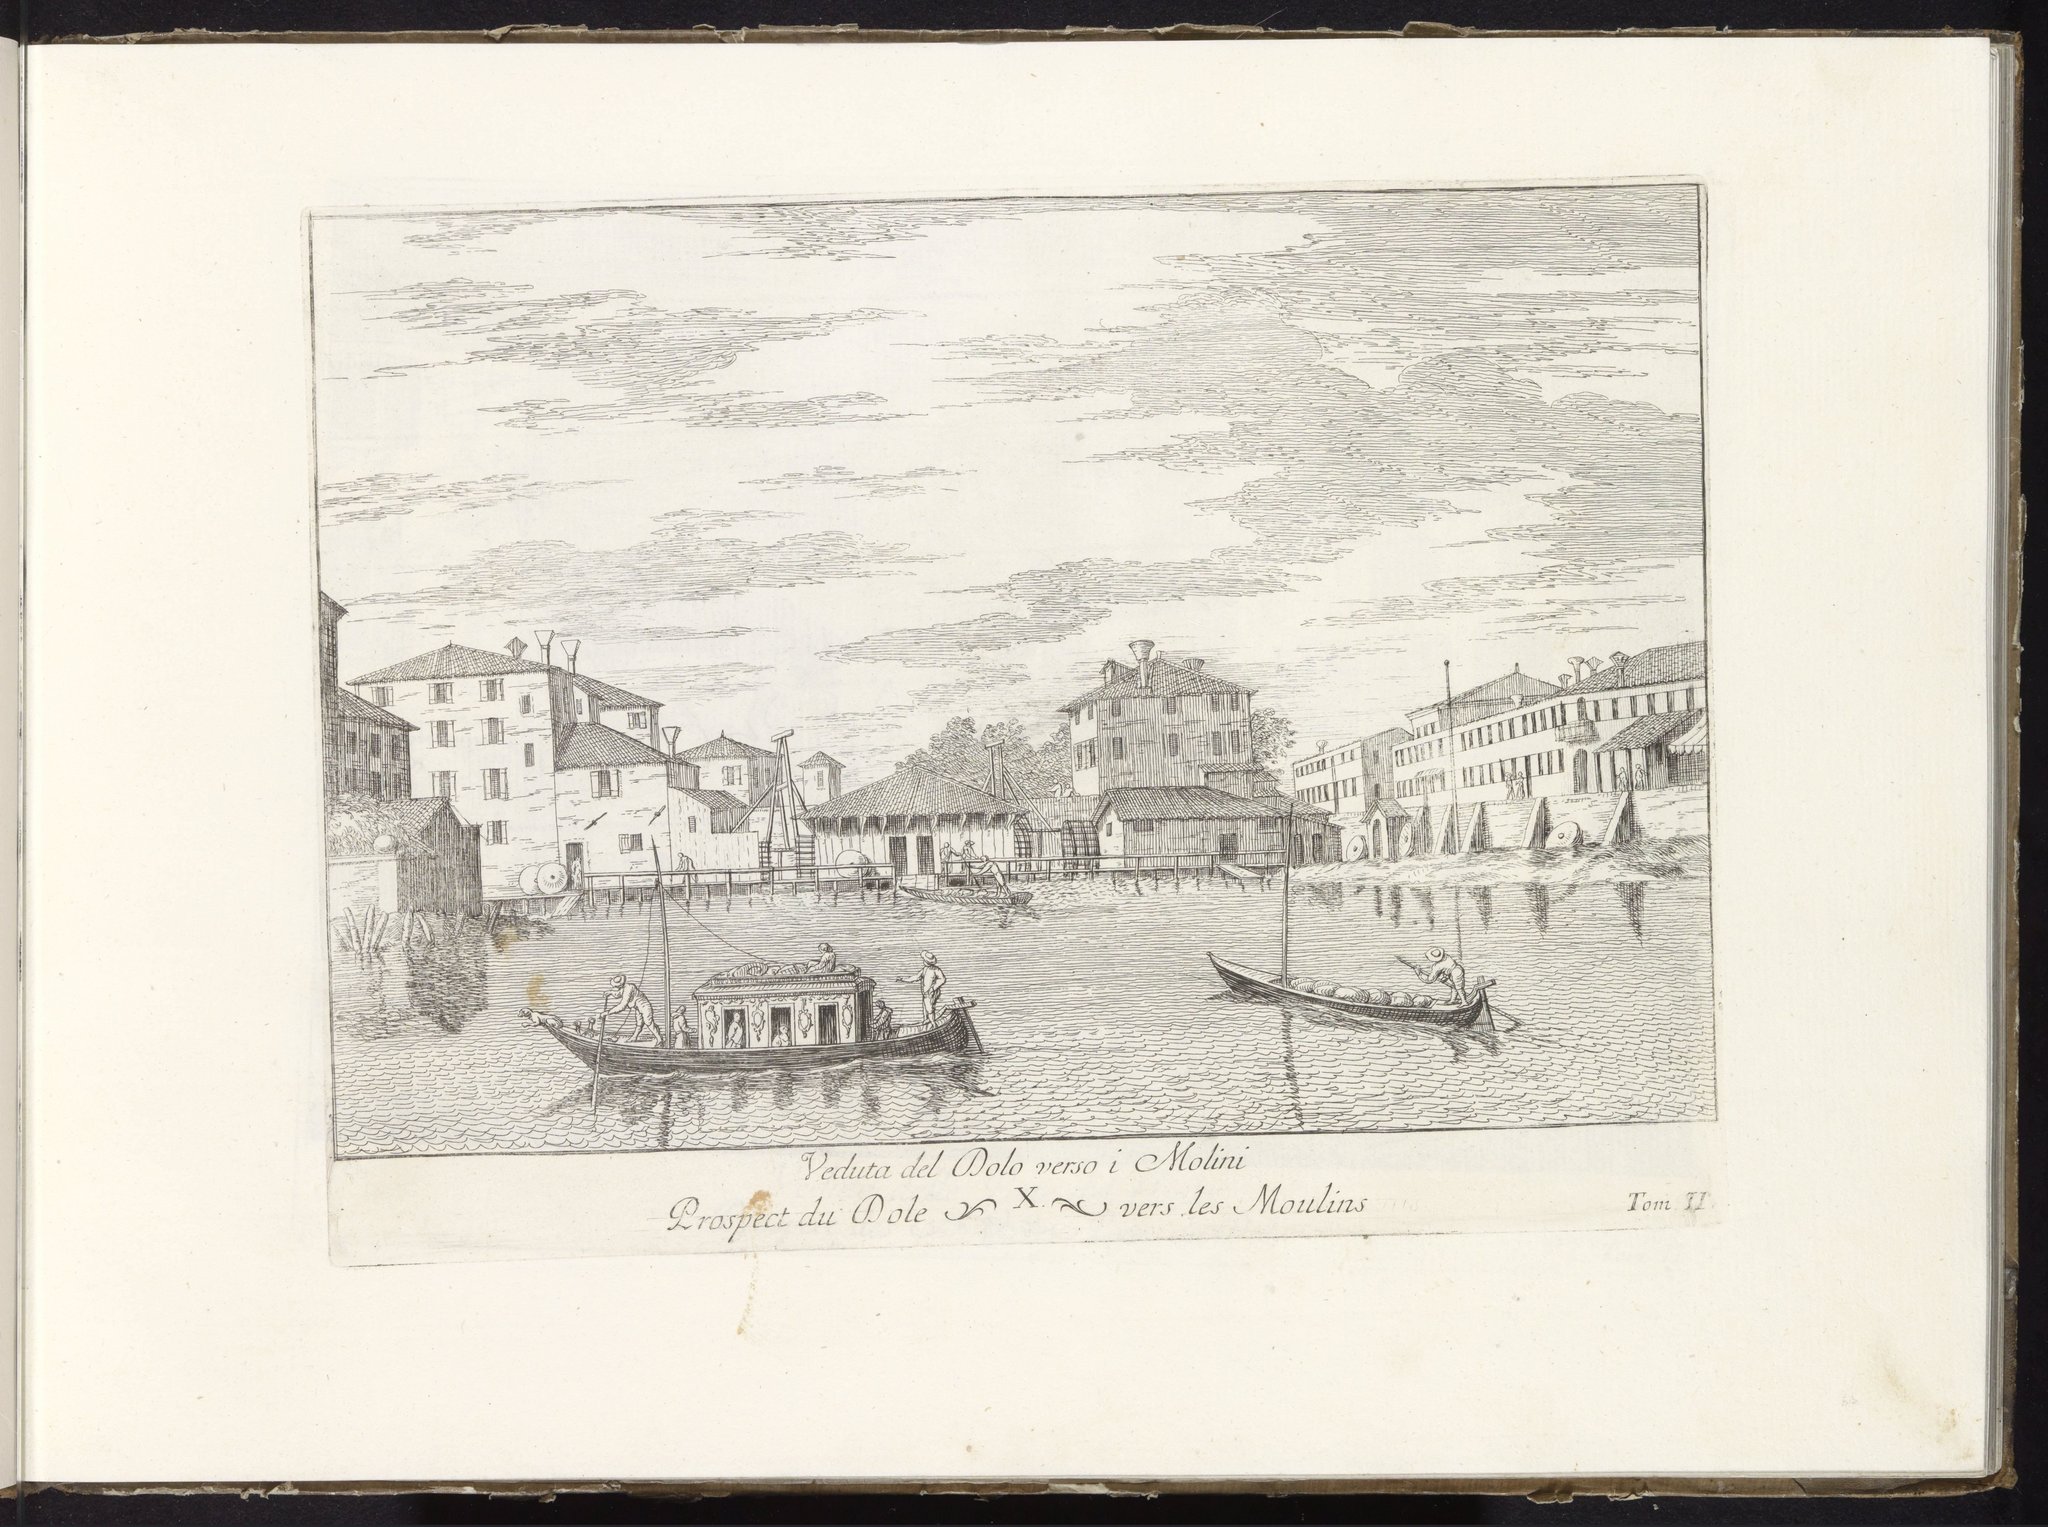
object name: print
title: Le delicie della Brenta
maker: giovanni francesco costa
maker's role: draughtsman, painter, print maker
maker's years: -1773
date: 1750-1760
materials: paper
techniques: etching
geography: venice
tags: river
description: Gezicht op Dolo richting Molini. Op de voorgrond stroomt de rivier de Brenta. Genummerd midden onder: X en rechtsonder: Tom: II. Deze prent maakt deel uit van een album.